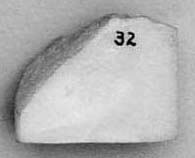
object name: fragment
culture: burmese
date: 1902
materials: jade